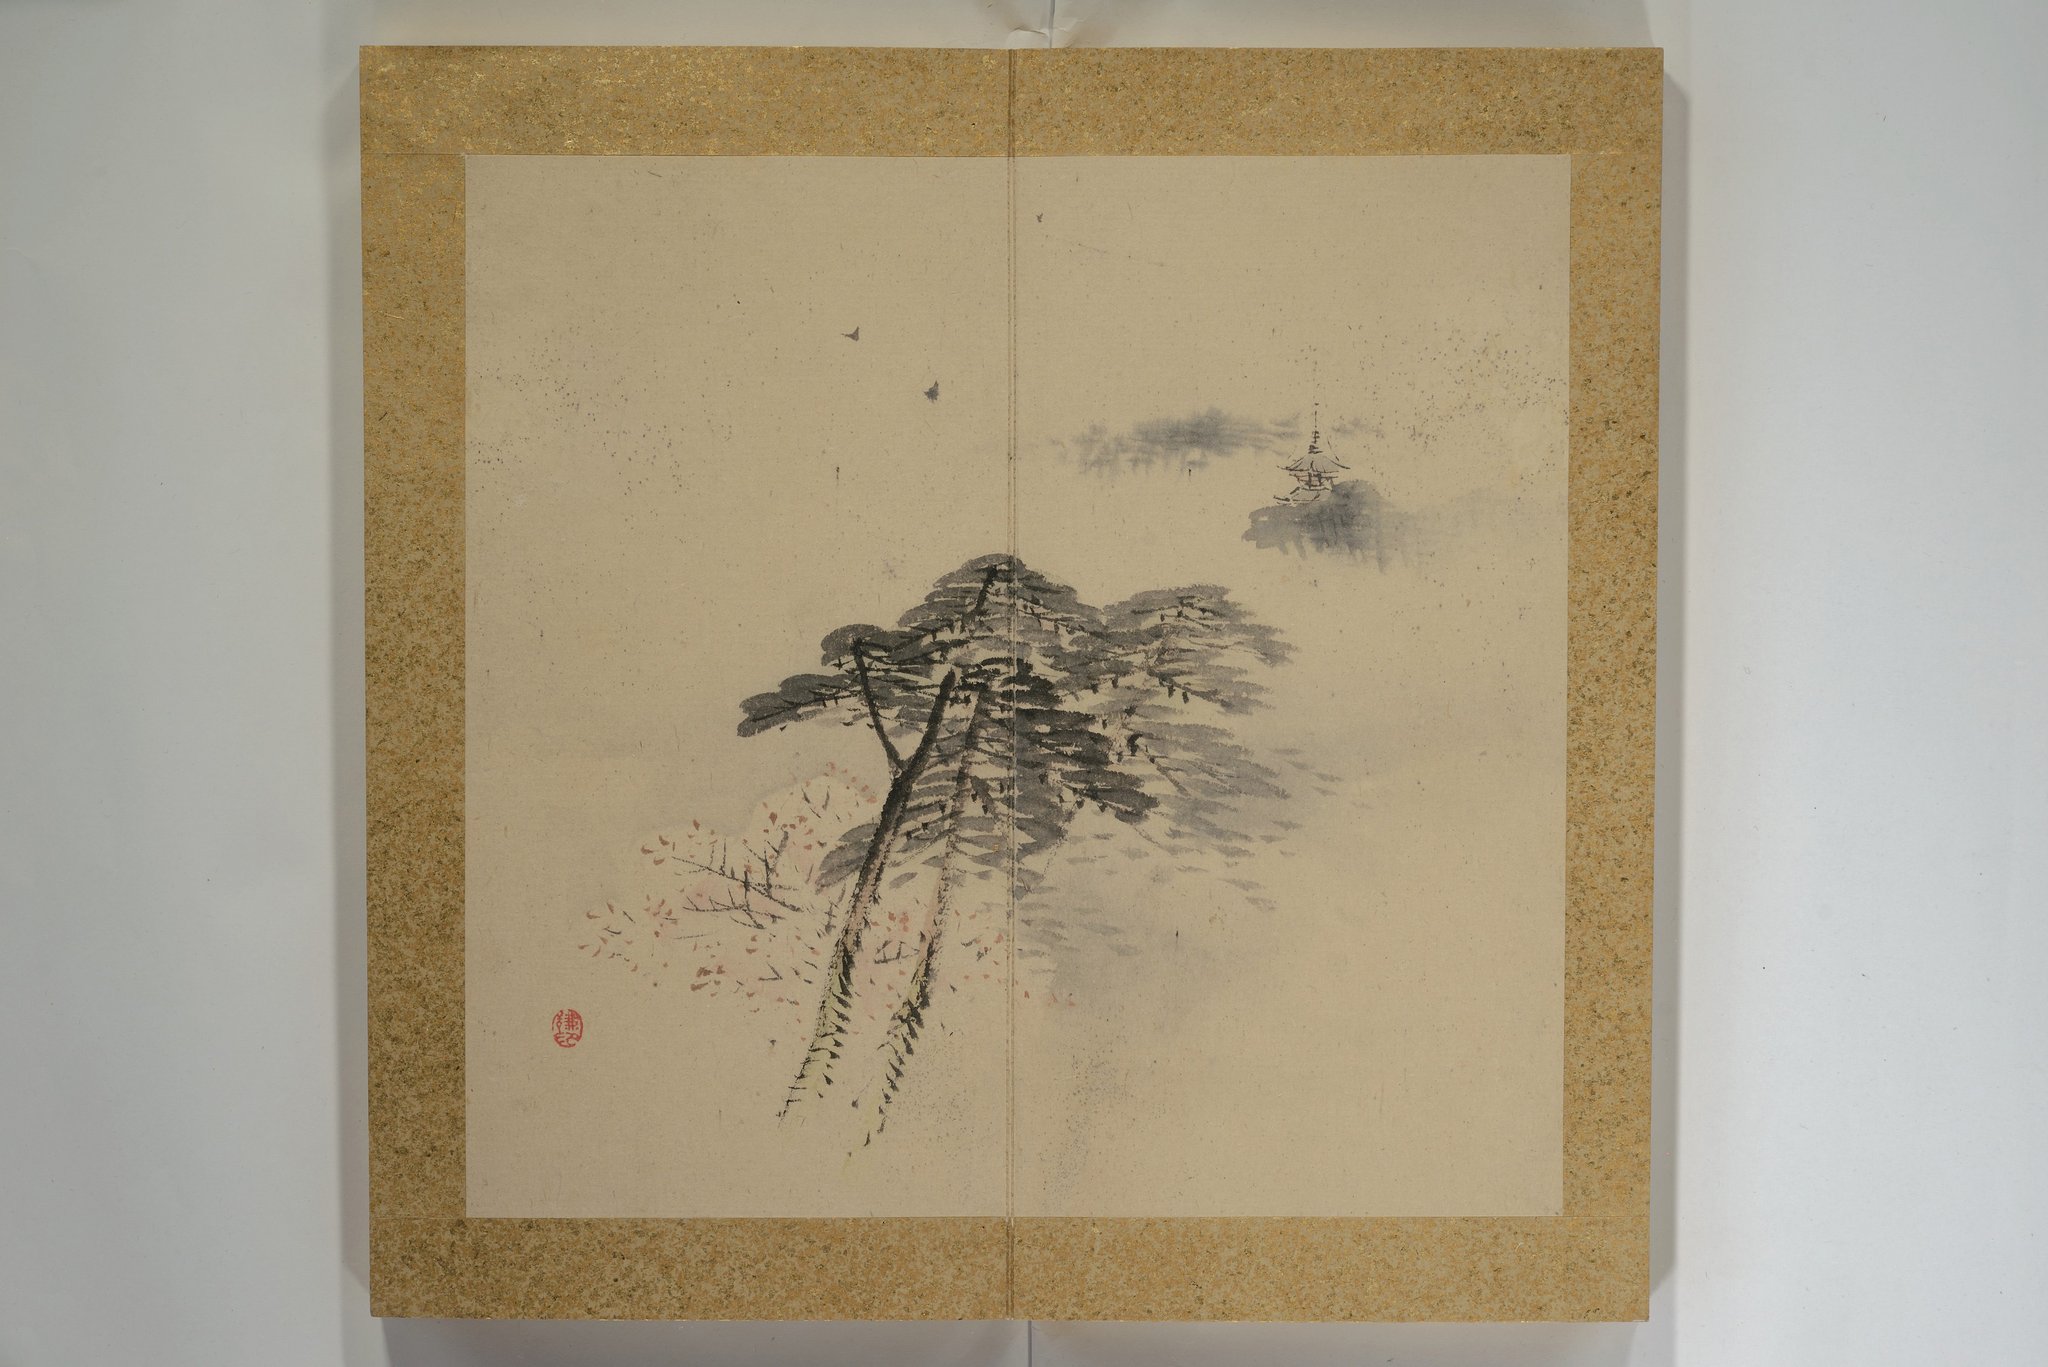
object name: illustrated book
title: Twelve Views of Naniwa (Osaka) (Naniwa jūnikei) なにわ十二景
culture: japanese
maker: nishiyama ken 西山謙一郎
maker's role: artist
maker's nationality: japanese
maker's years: 1833-1897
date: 1801-1900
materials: ink, paper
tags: trees